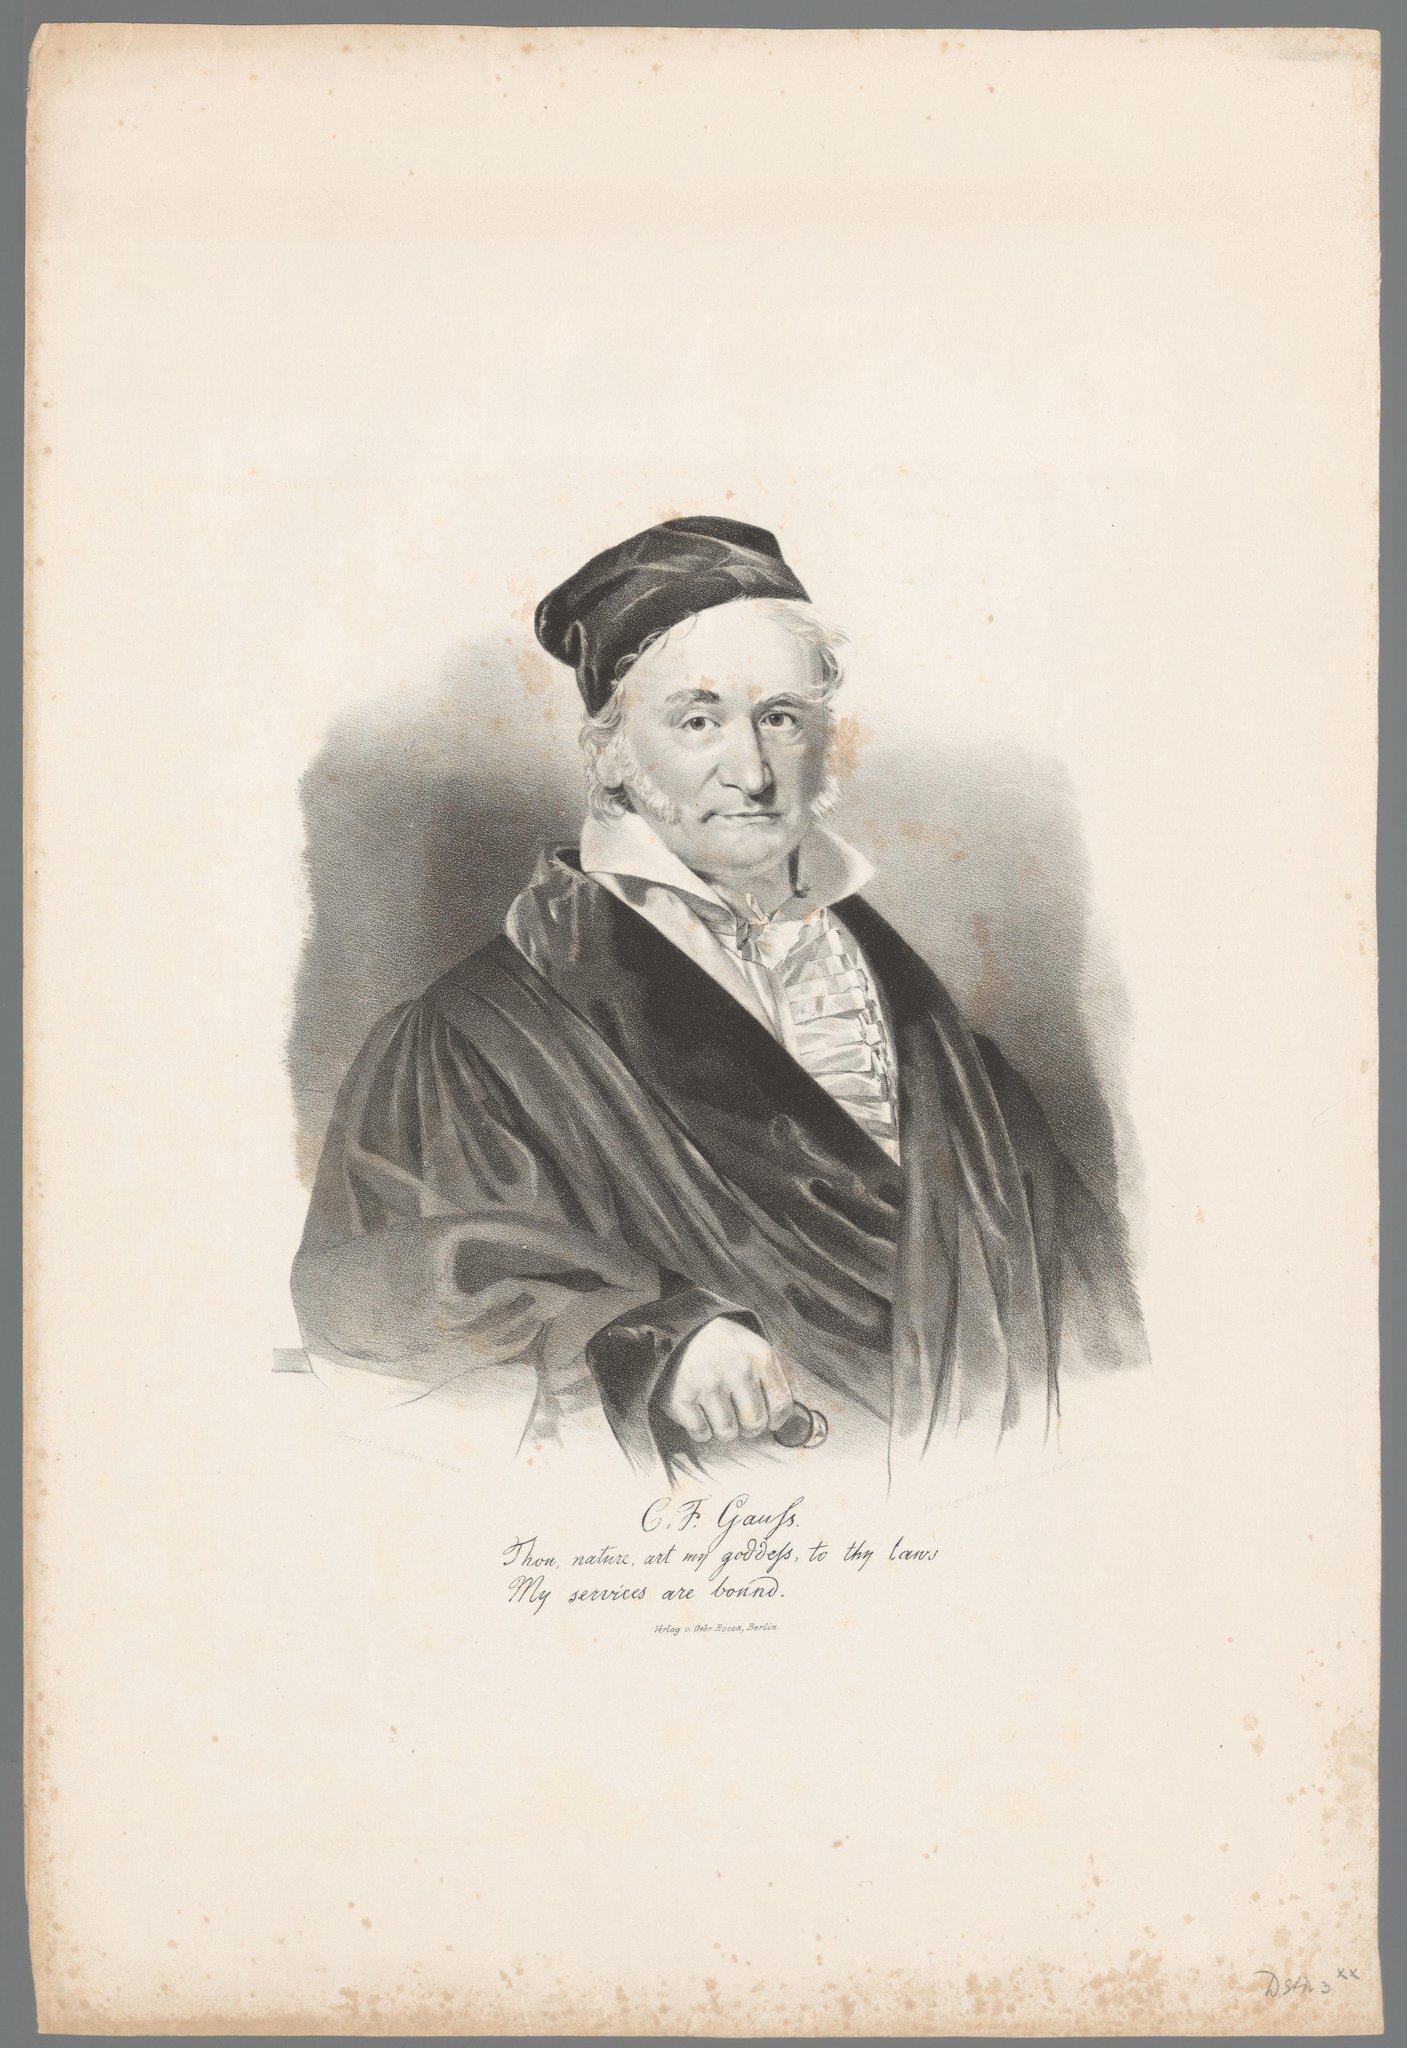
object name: print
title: Portret van Carl Friedrich Gauss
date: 1830-1863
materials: paper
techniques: lithograph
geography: berlin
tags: historical persons, mathematics (+ portrait of scholar, scientist)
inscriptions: collector's mark: Lugt 2228